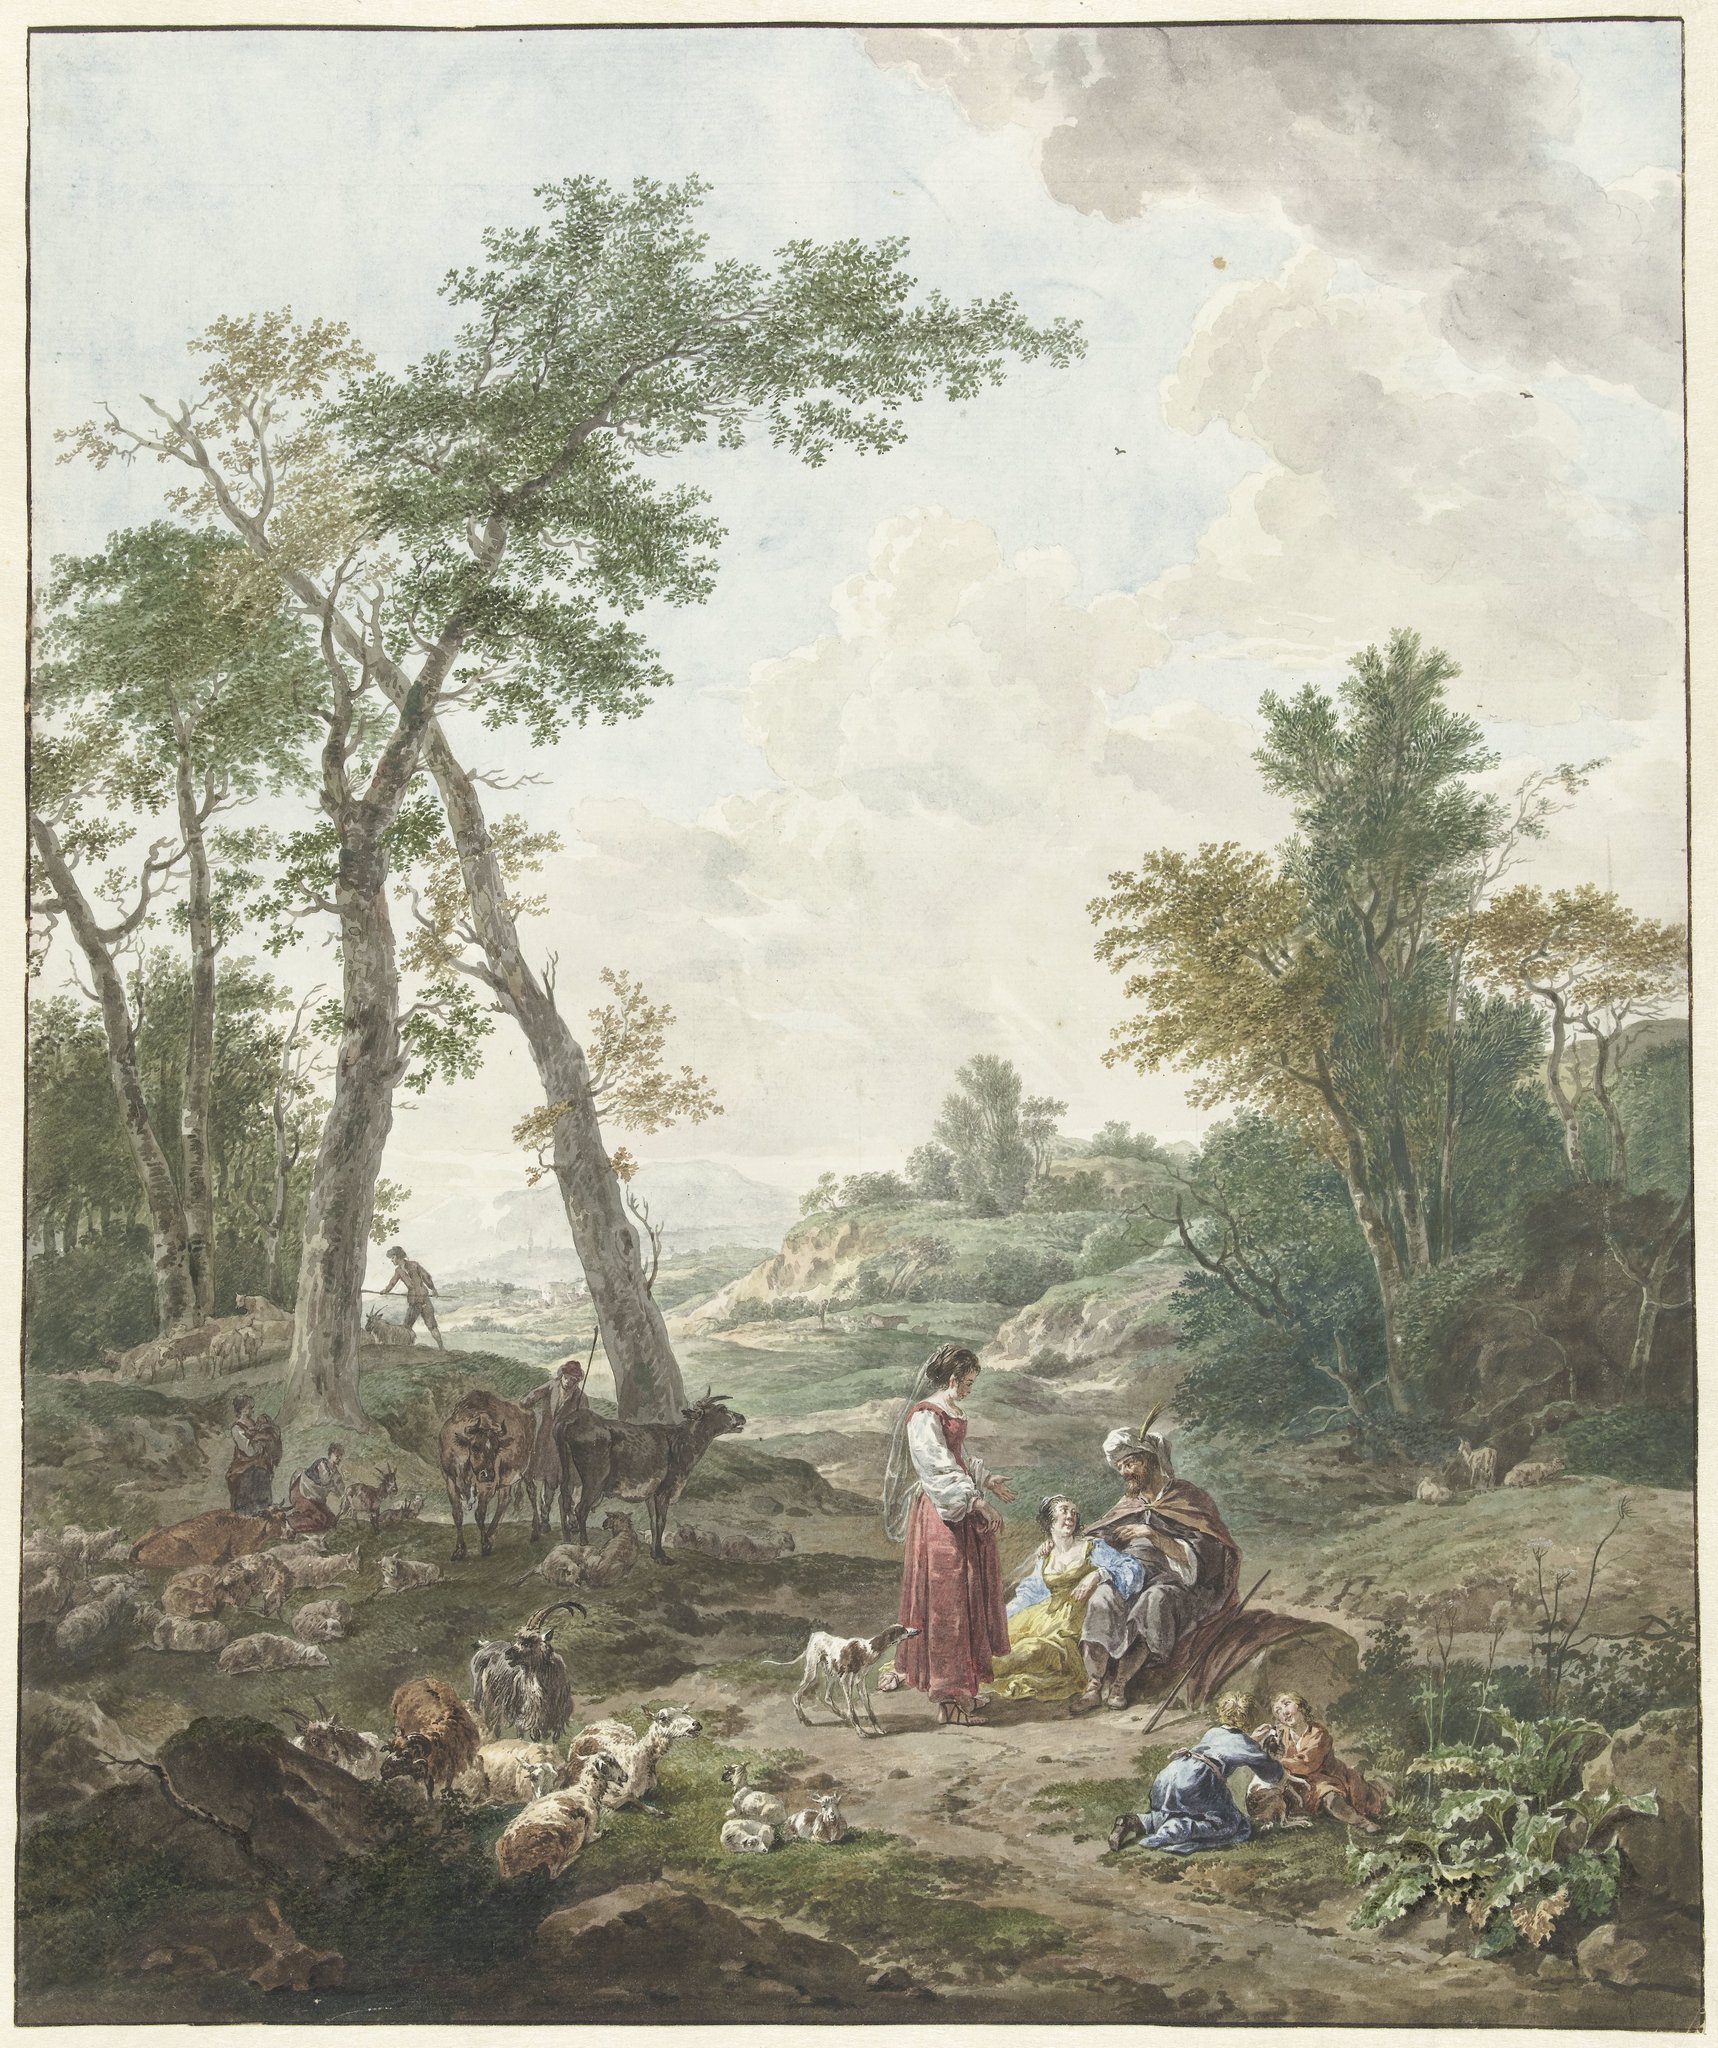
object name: drawing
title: Elkanah and His Wives Hannah and Peninnah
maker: wybrand hendriks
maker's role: draughtsman, painter, print maker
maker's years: 1744-1831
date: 1777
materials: ink, paper, pencil, watercolor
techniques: brush, pen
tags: childlessness of hannah, wife of elkanah